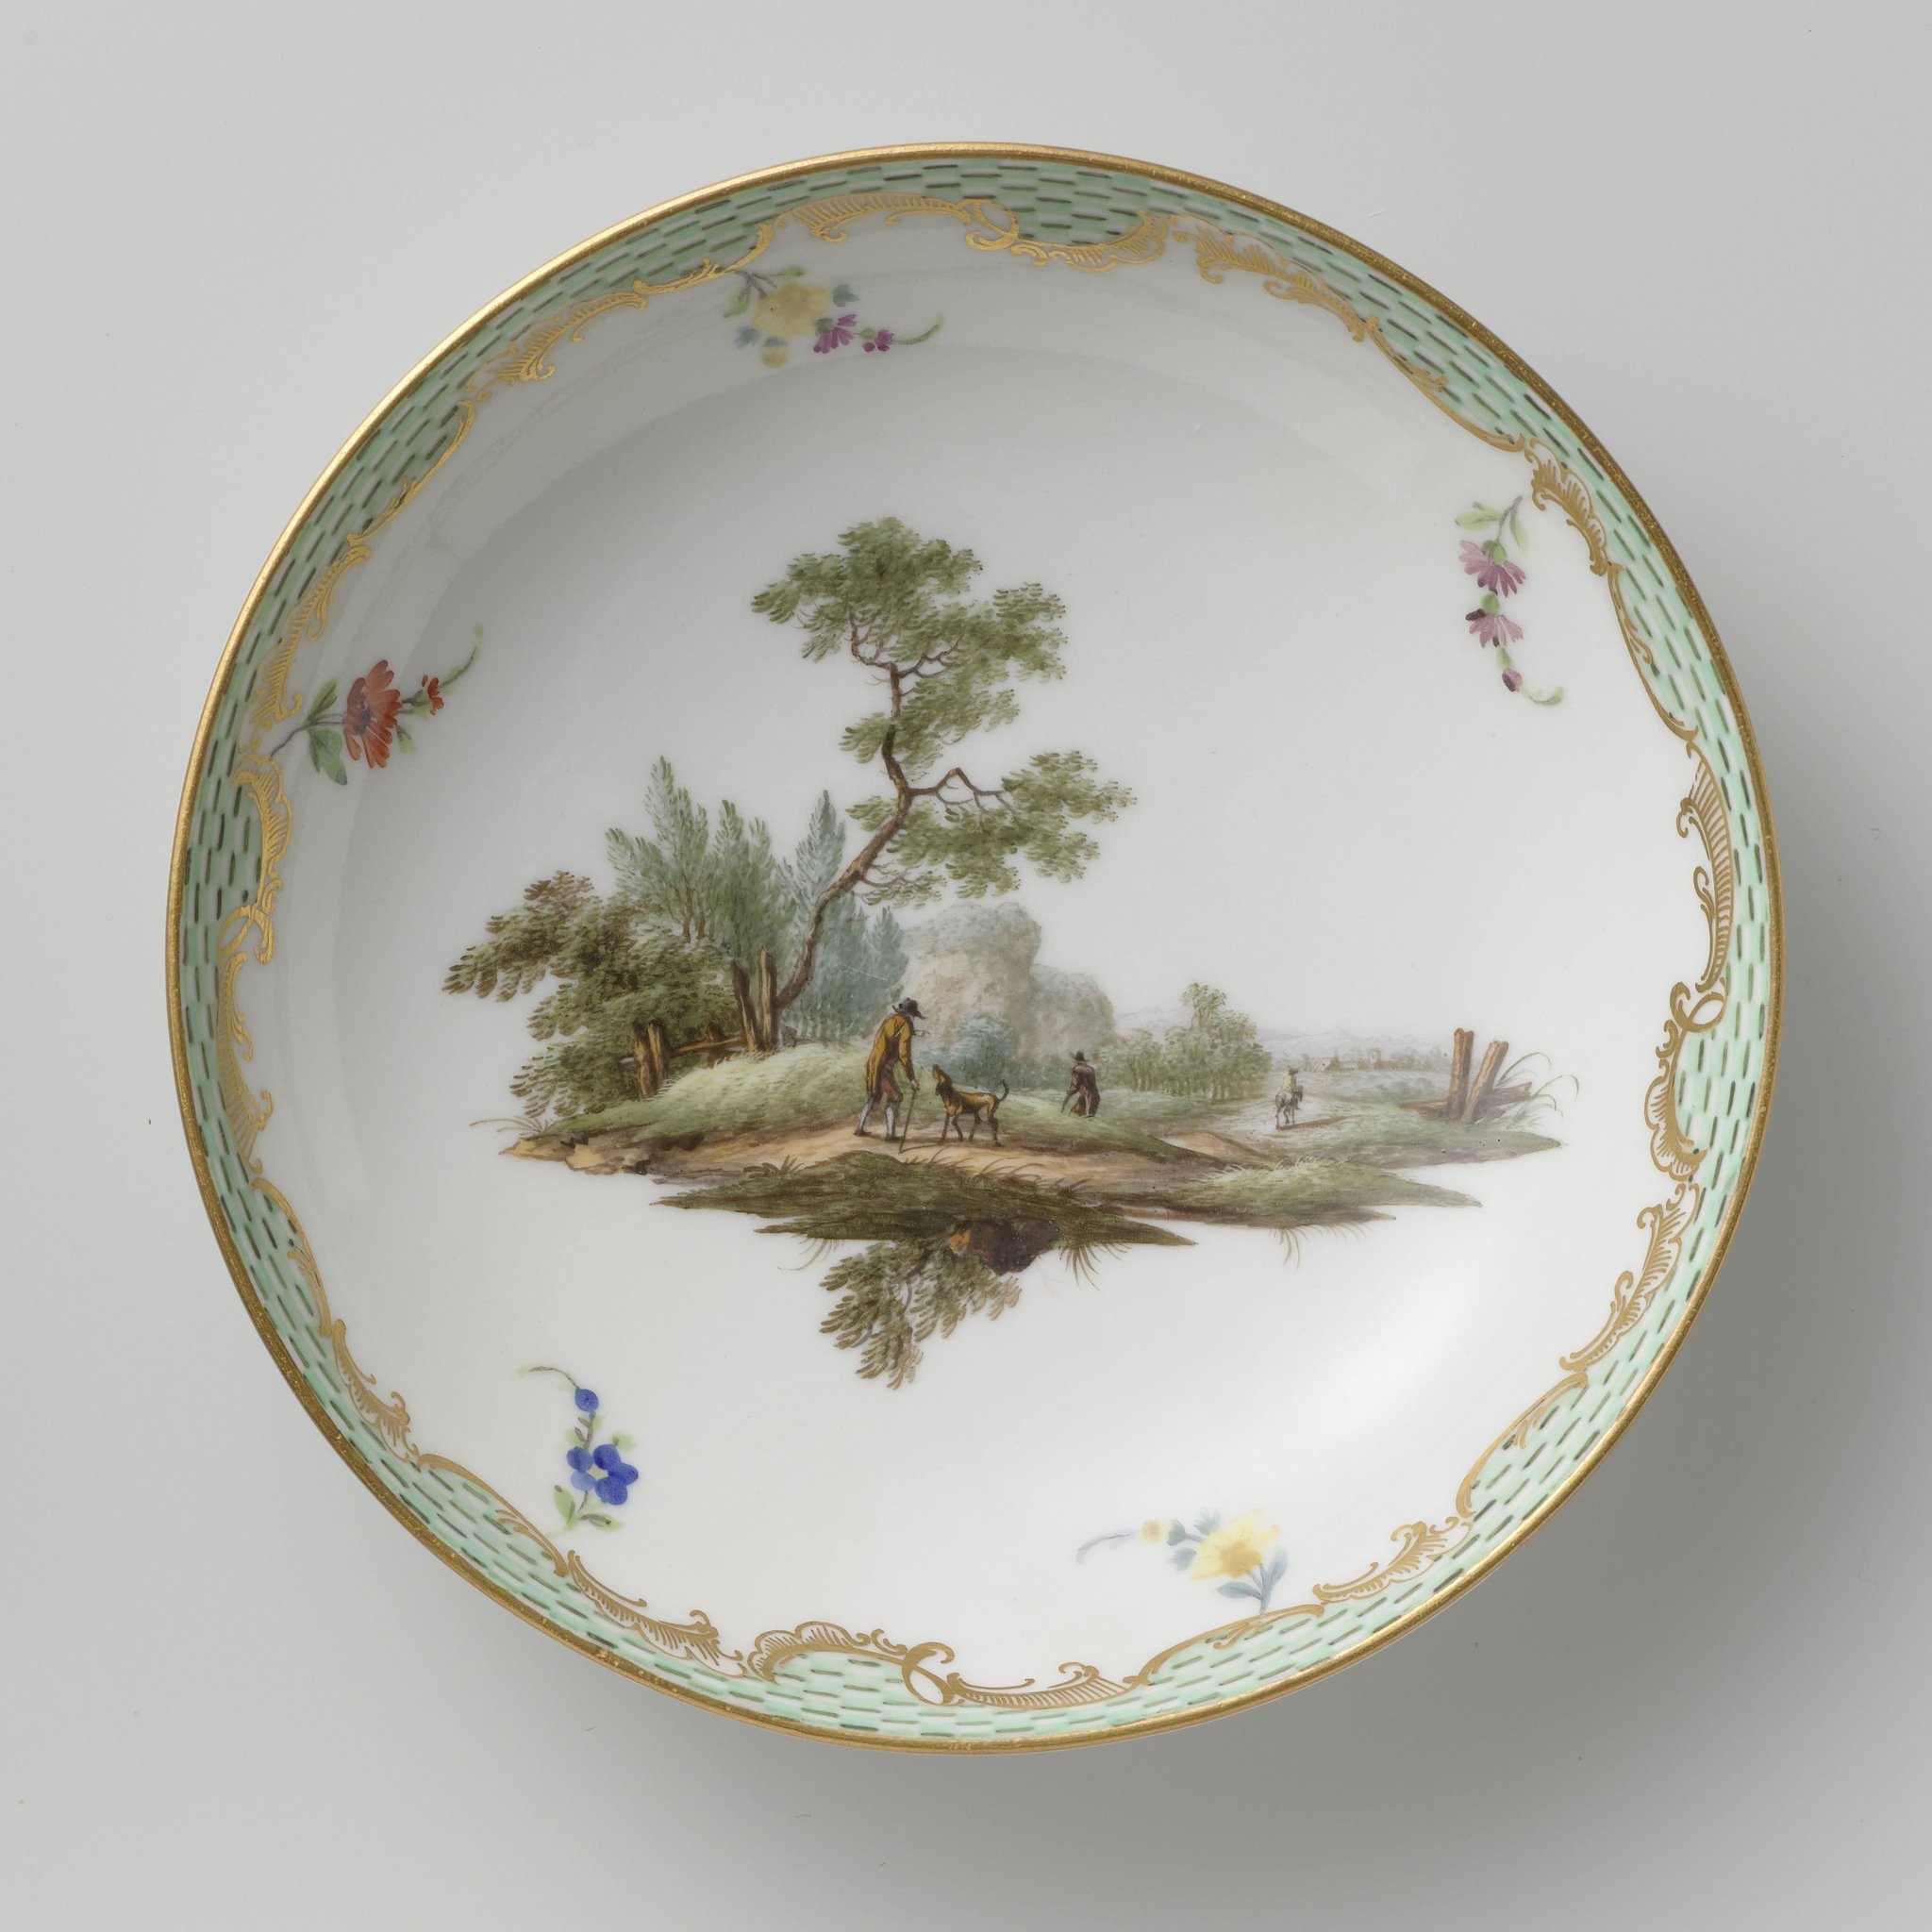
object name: platter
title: Schotel, veelkleurig beschilderd met een landschap met figuren.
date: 1777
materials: porcelain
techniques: painted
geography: meissen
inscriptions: factory mark, mold mark: ‘5’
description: Ronde schotel van beschilderd porselein. De schotel is beschilderd met landschappen waarin figuren en langs de rand een brede strook groen vlechtwerk. De schotel is gemerkt.